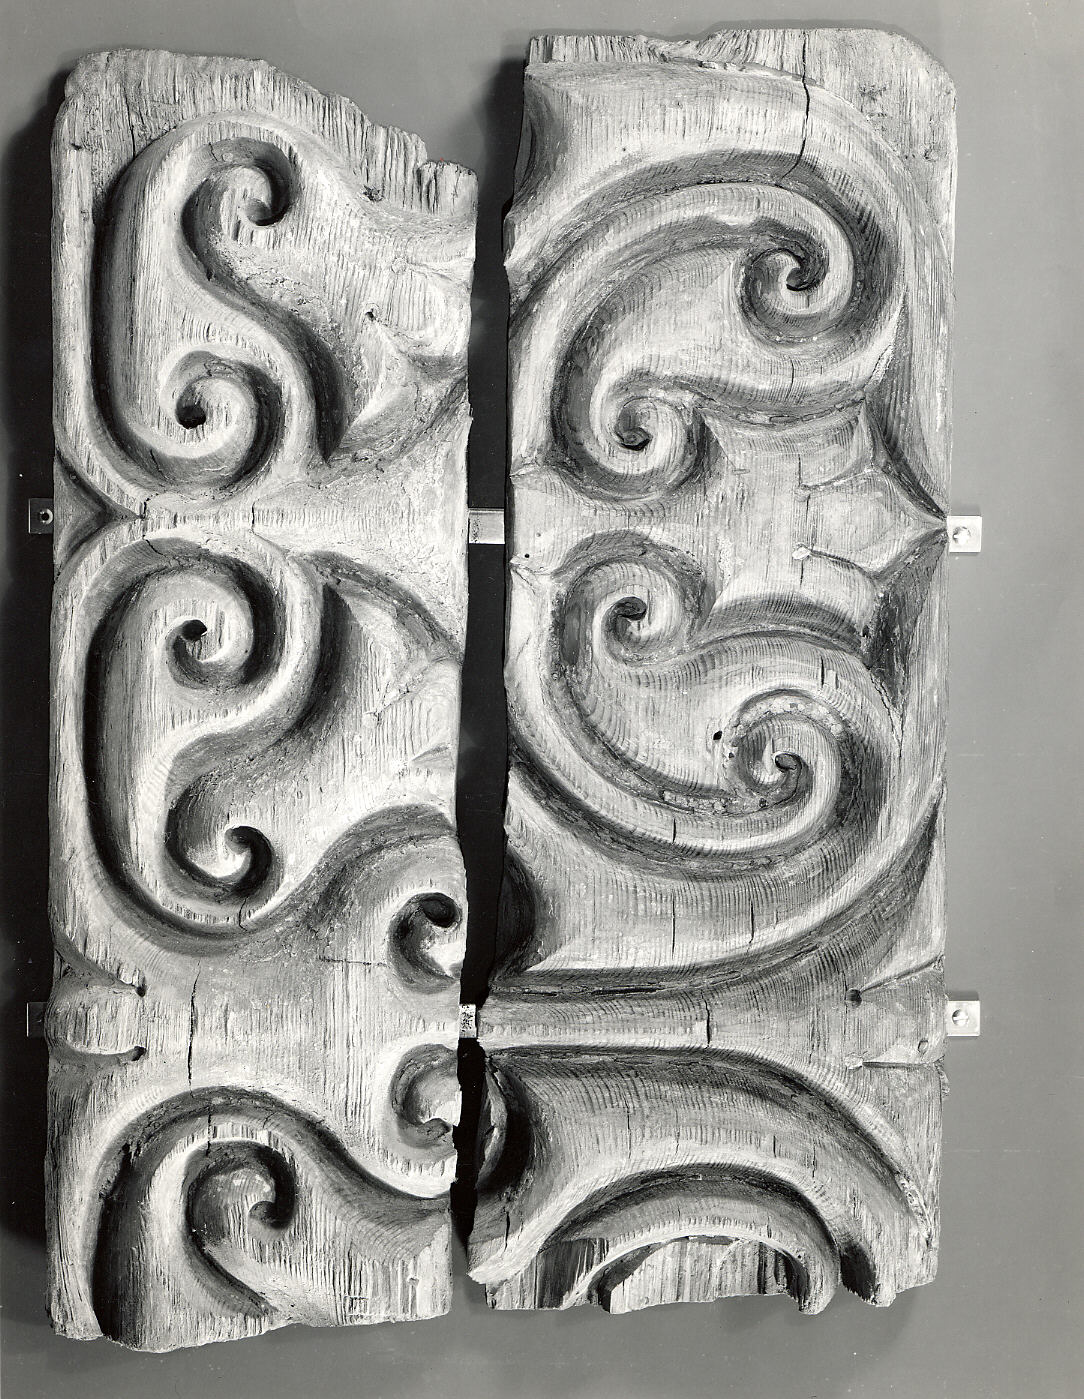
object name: panel fragment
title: Panel Carved in the "Beveled Style" with Remains of Later Polychromy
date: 976-1000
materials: wood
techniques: carving, gilding, painting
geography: egypt